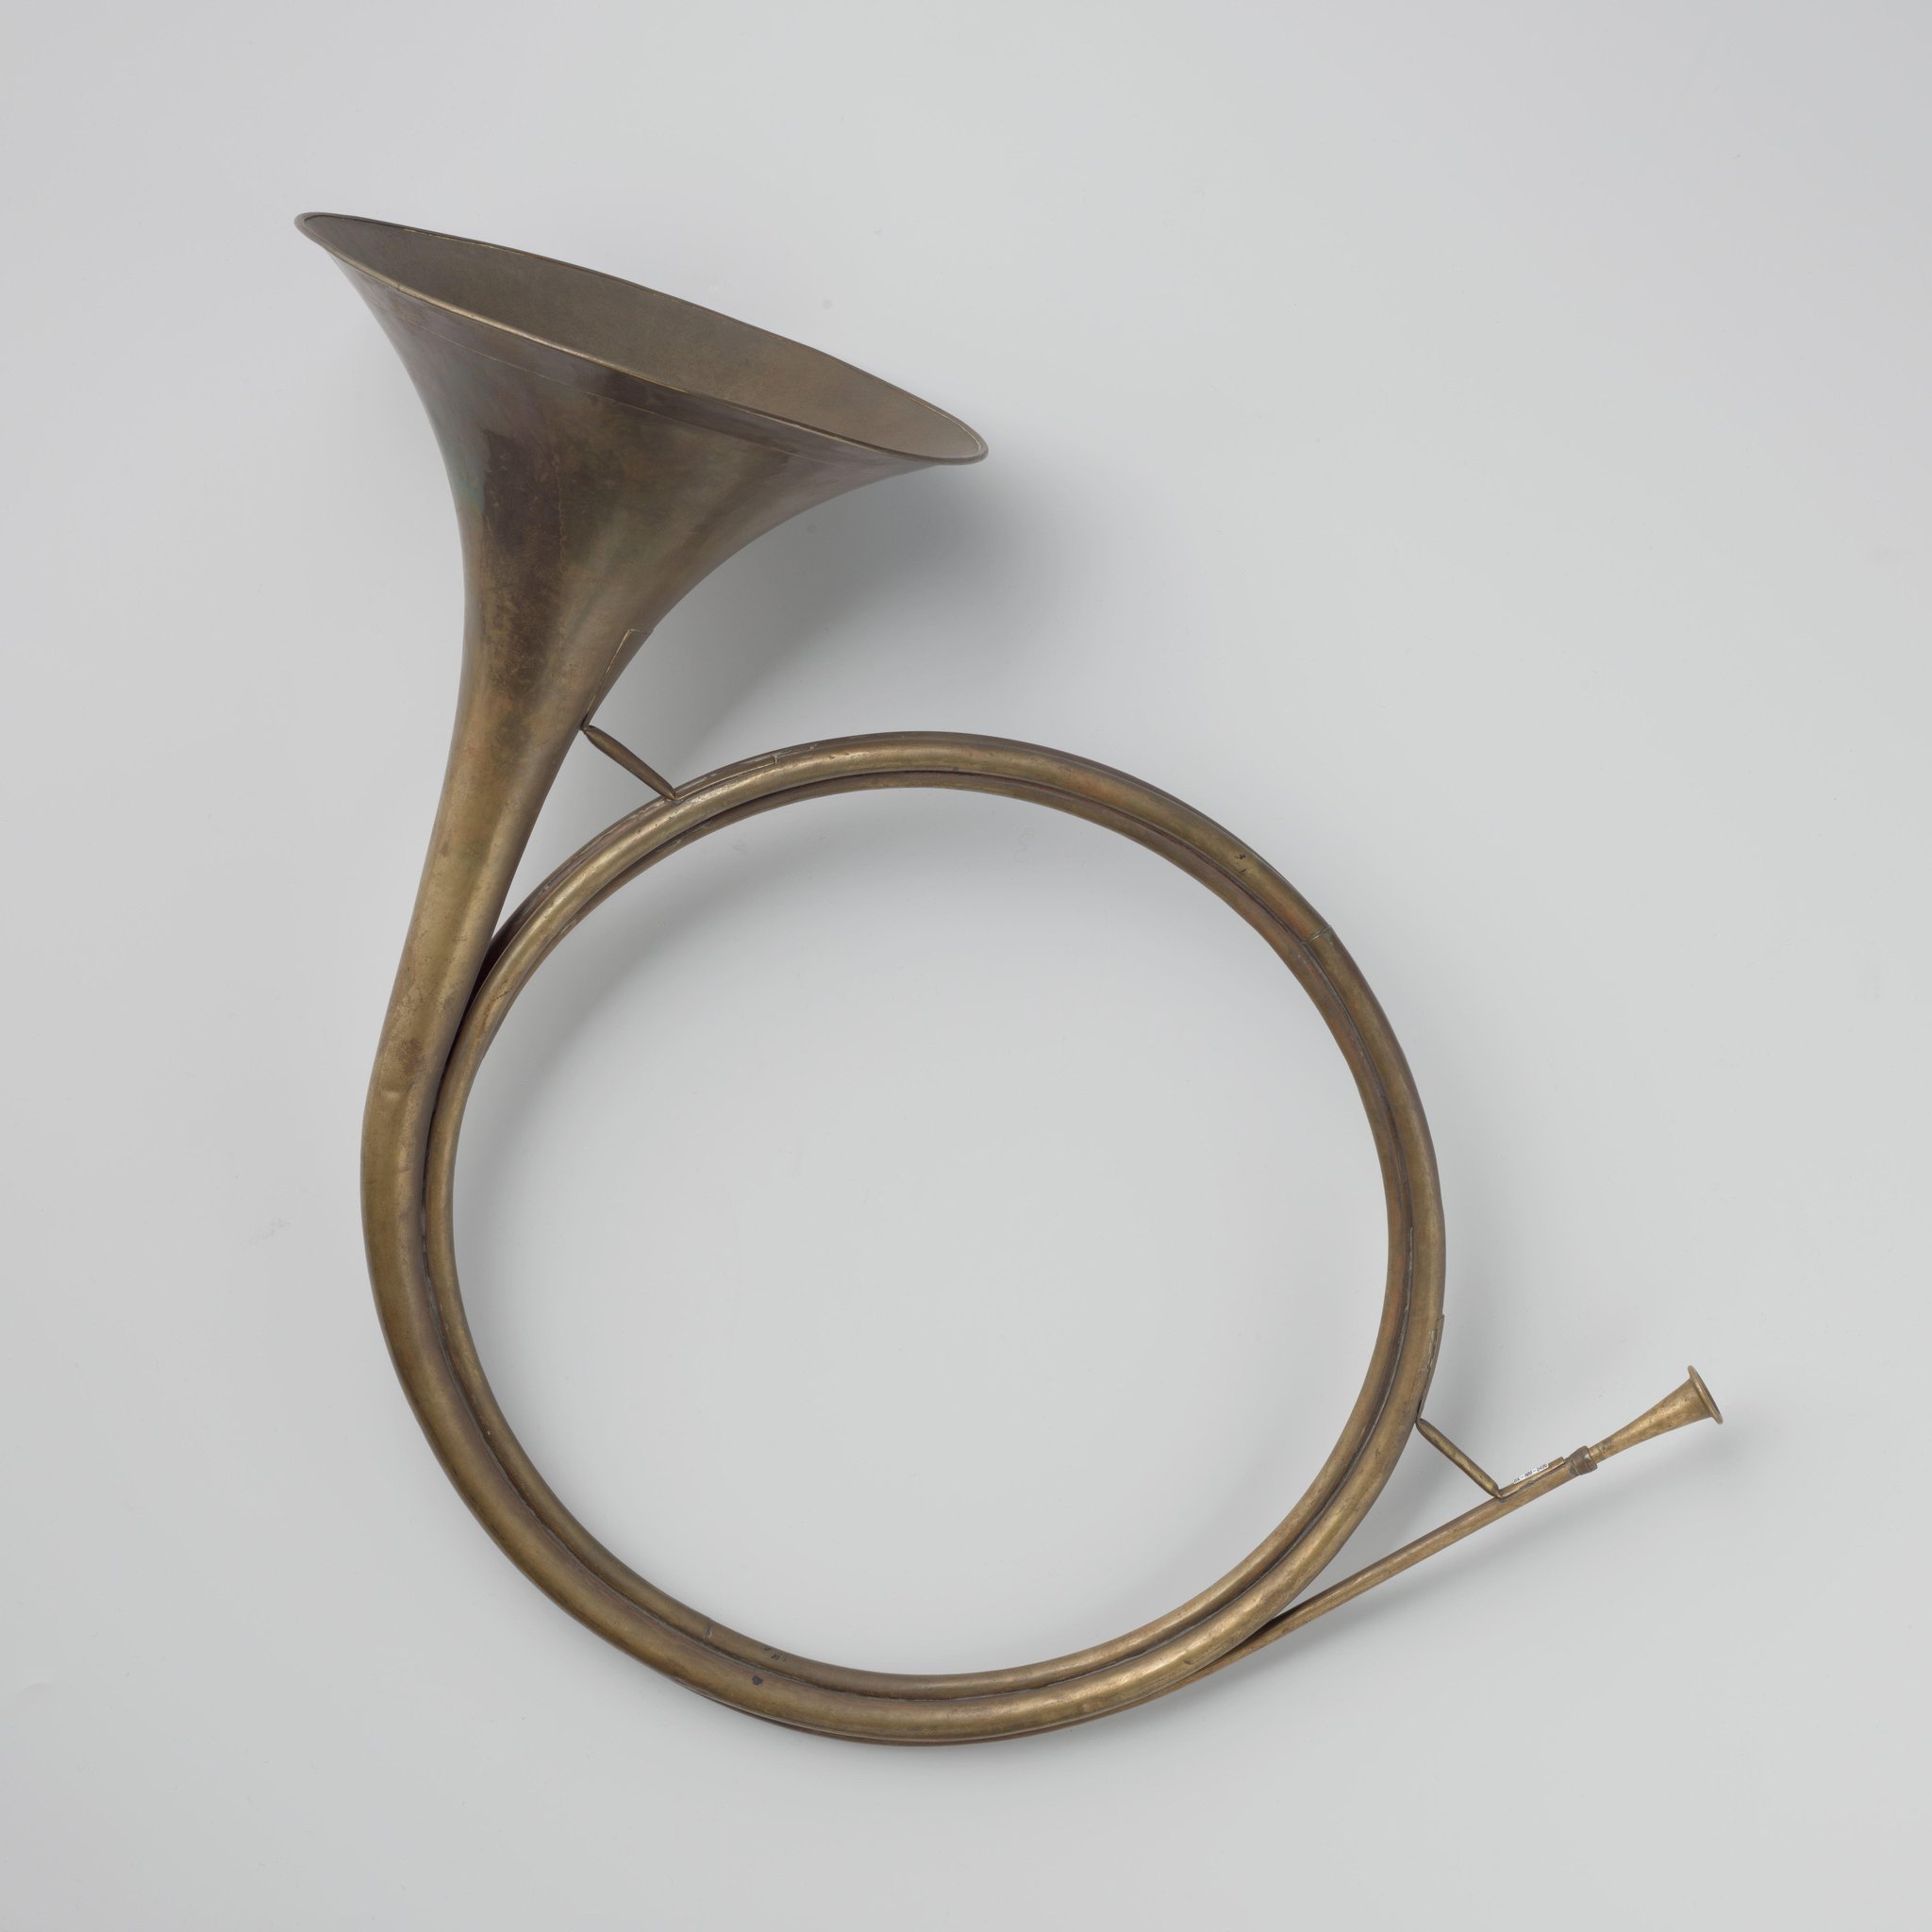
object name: wind instrument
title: Natural horn (hunting horn)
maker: françois perinet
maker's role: musical instrument maker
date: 1840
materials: copper, silver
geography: paris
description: Natuurhoorn in D. Rond de beker is een krans gelegd, warin gegraveerd: FRANCOIS PERINET, RUE BOURBON VILLENEUVE A PARIS. Op de beker: BREVETE.